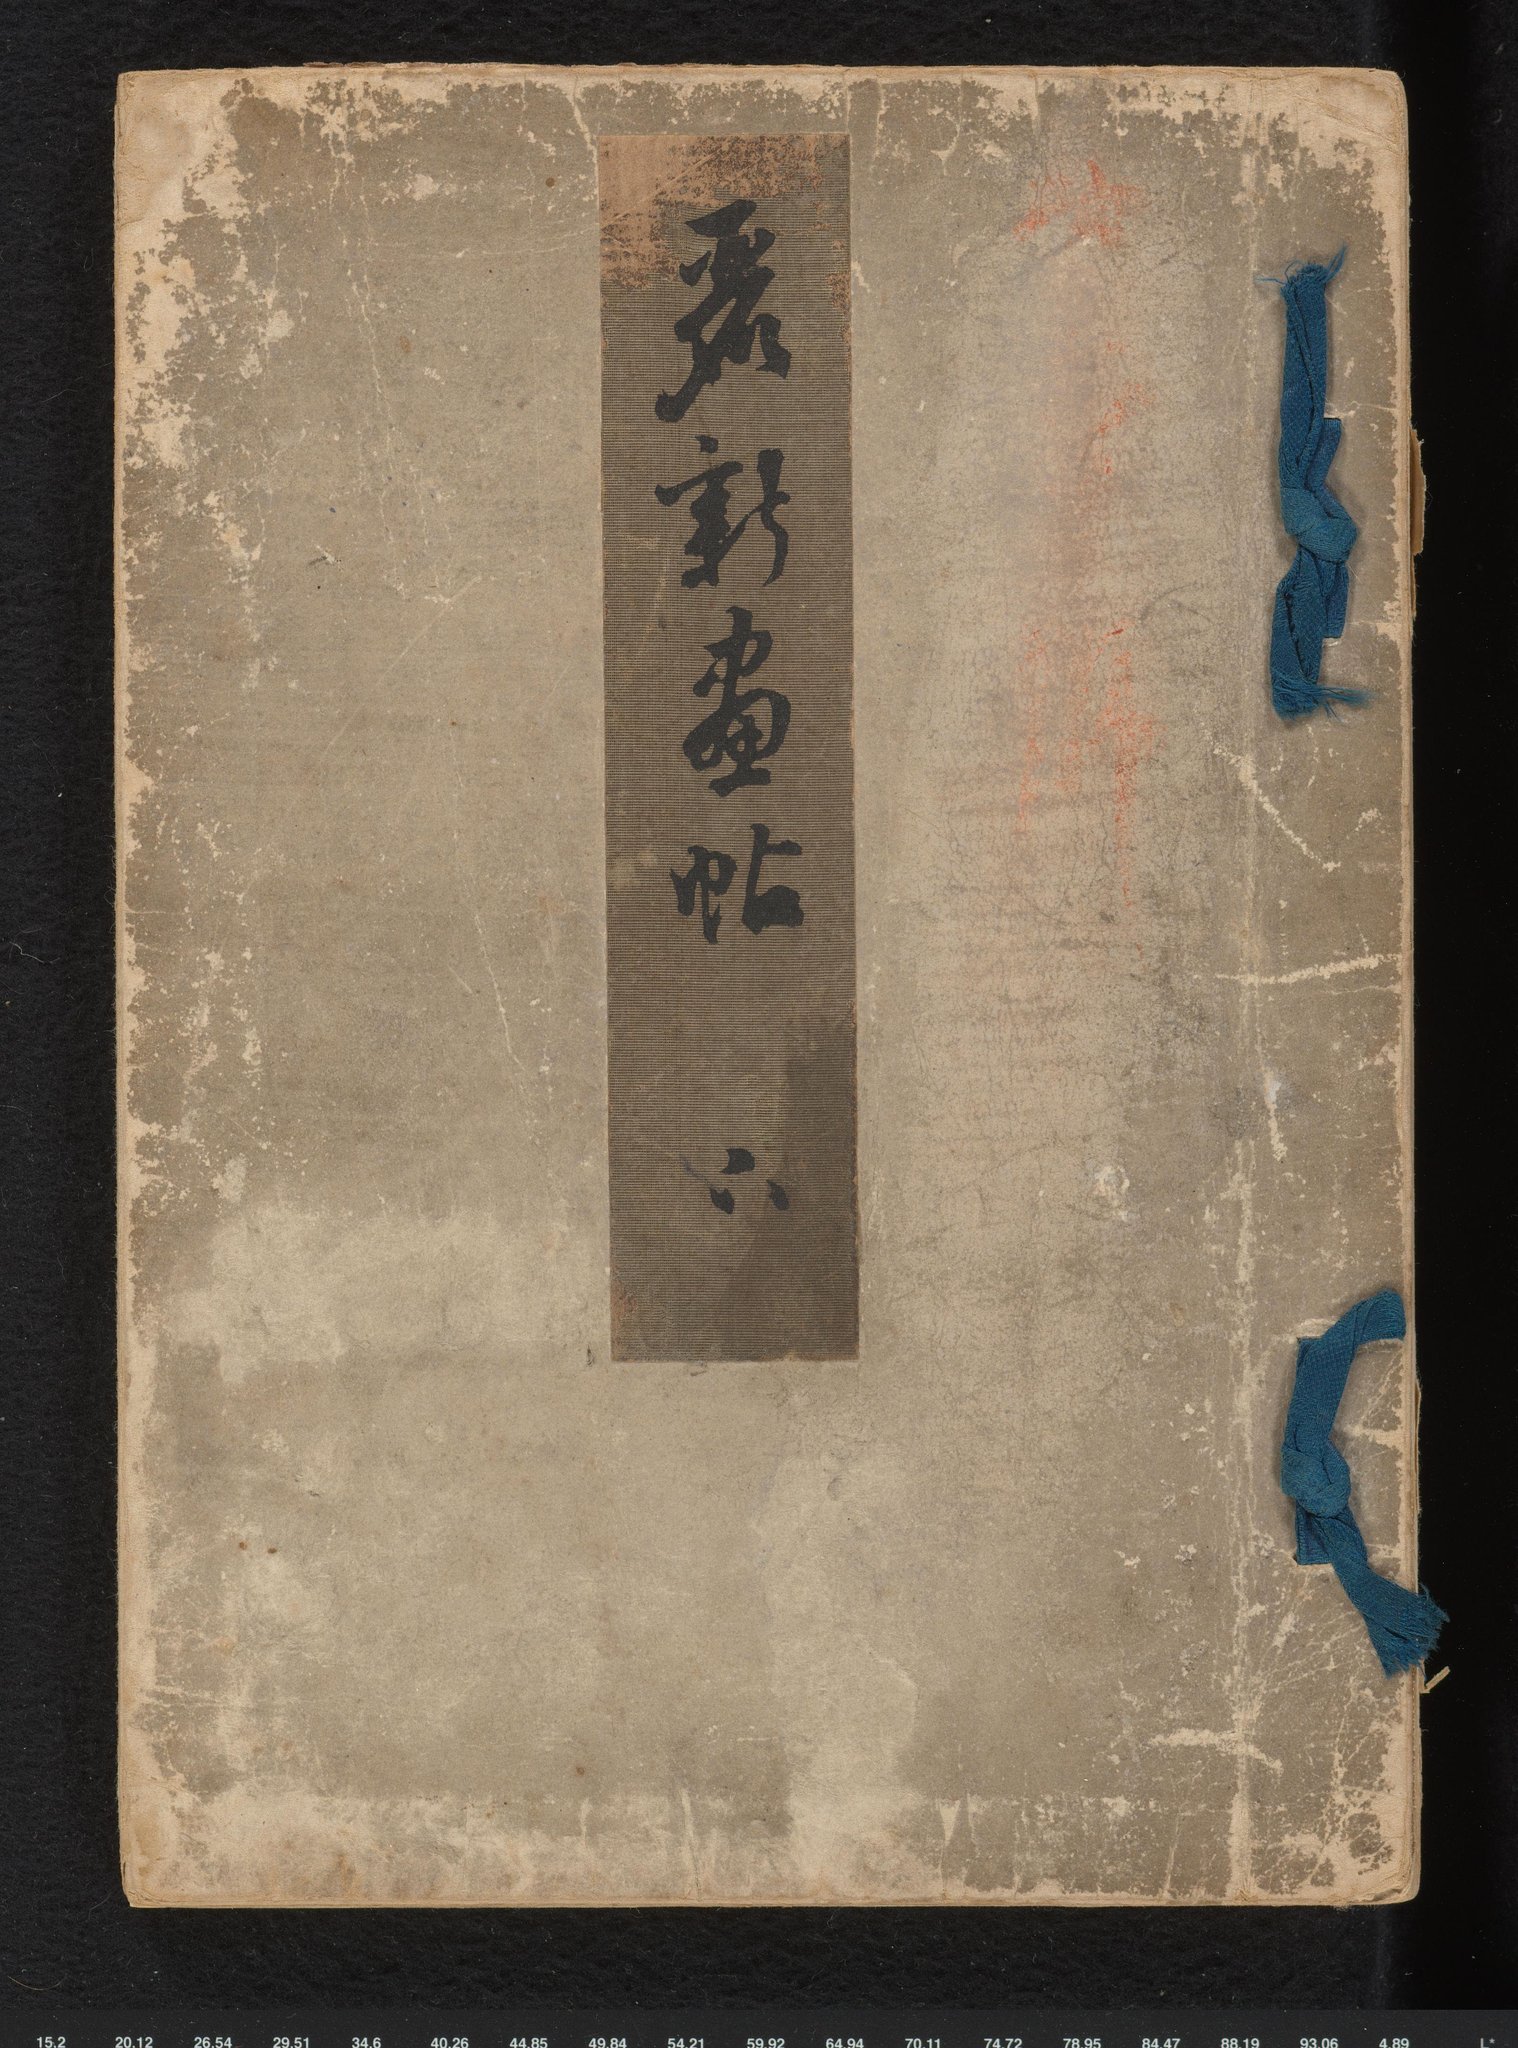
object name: book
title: Reishin gajo - jo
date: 1900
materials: paper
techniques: woodcut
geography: kyoto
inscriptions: date